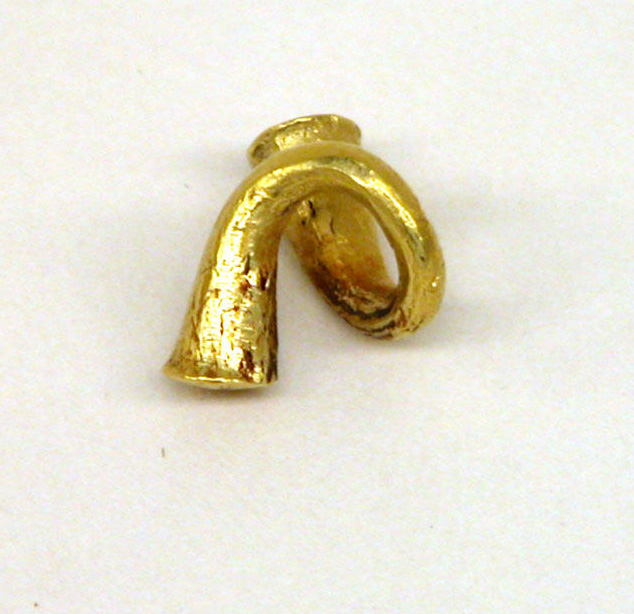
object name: ear ornament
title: Ear Ornament in Twisted Shape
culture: indonesian, javanese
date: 201-300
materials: gold